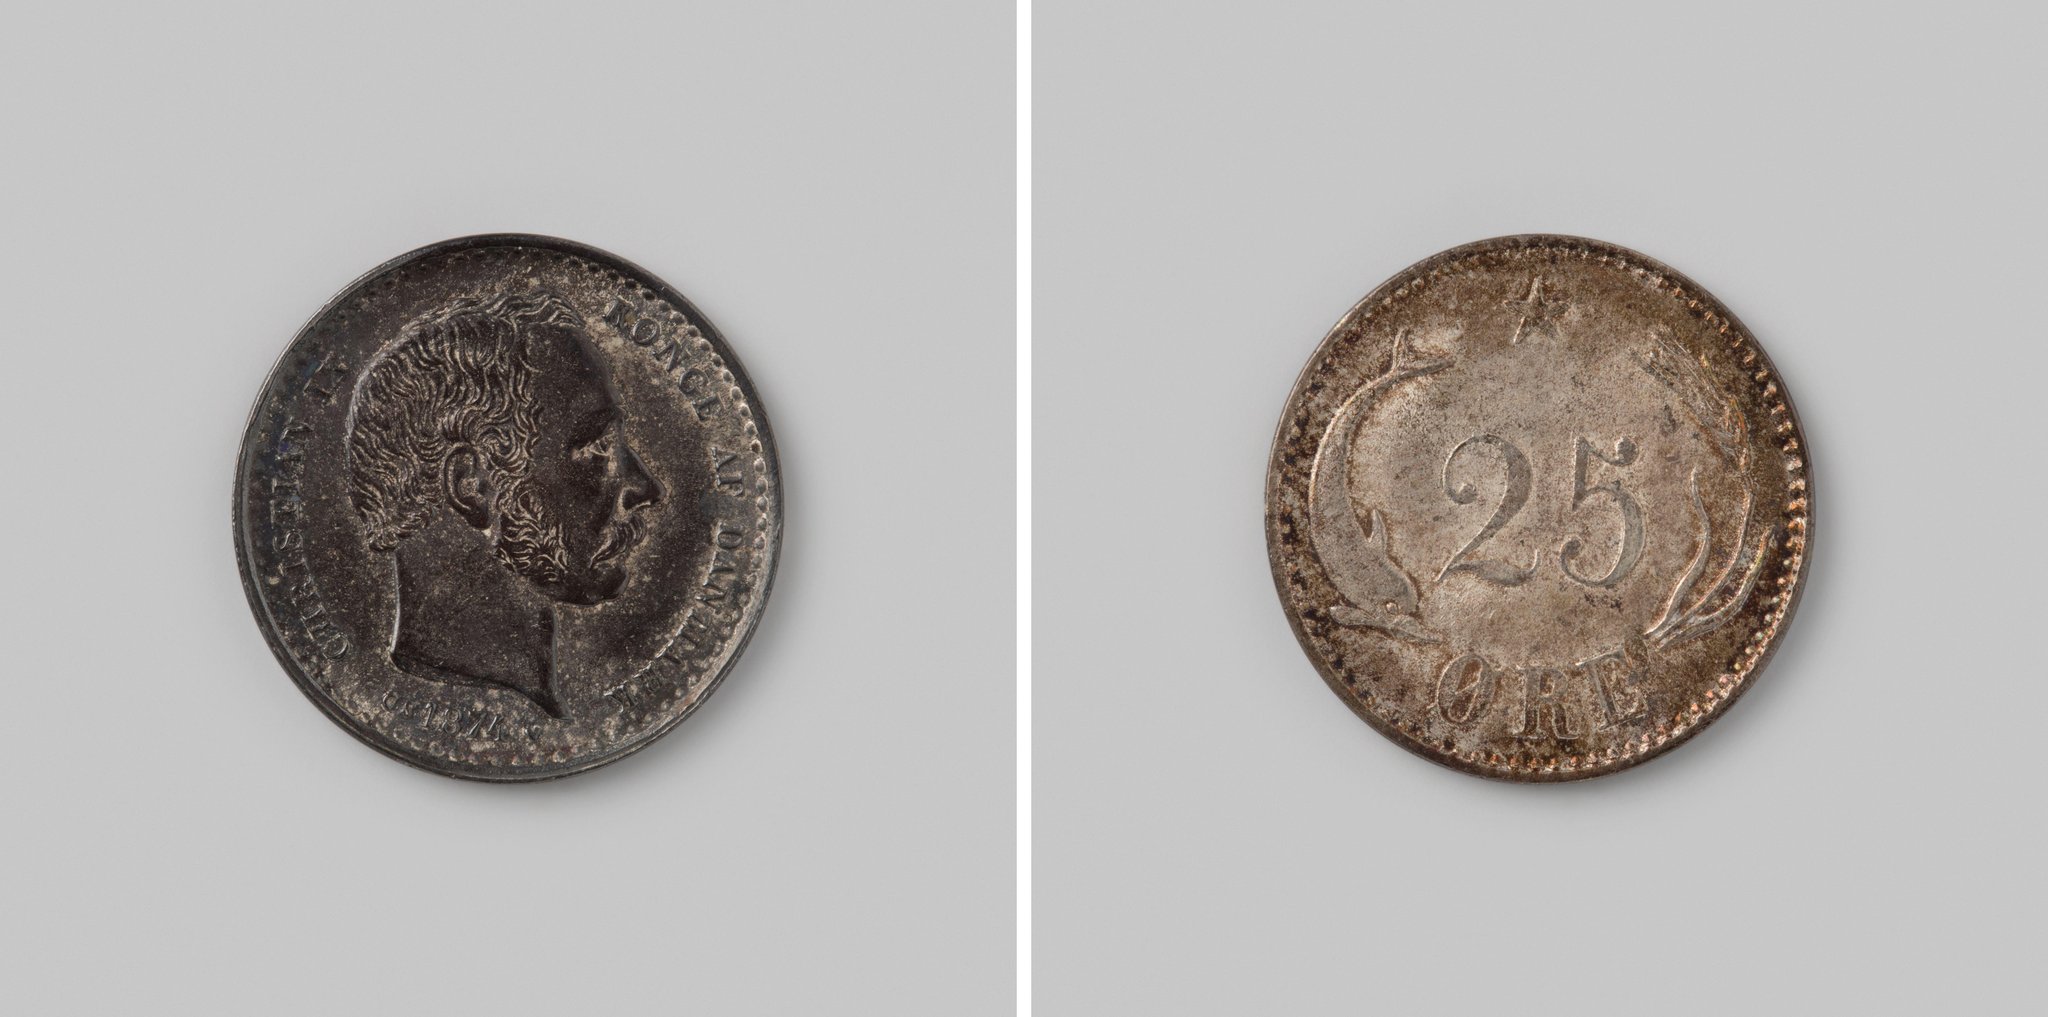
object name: vijfentwintig øre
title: 25 øre uit Denemarken van Christiaan IX, 1874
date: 1874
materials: silver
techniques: striking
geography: copenhagen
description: Zilveren munt. Voorzijde: hoofd van de koning naar rechts. Daaronder jaartal. Keerzijde: tussen dolfijn en tak in twee regels waarde-aanduiding. Daarboven ster. Gladde rand.